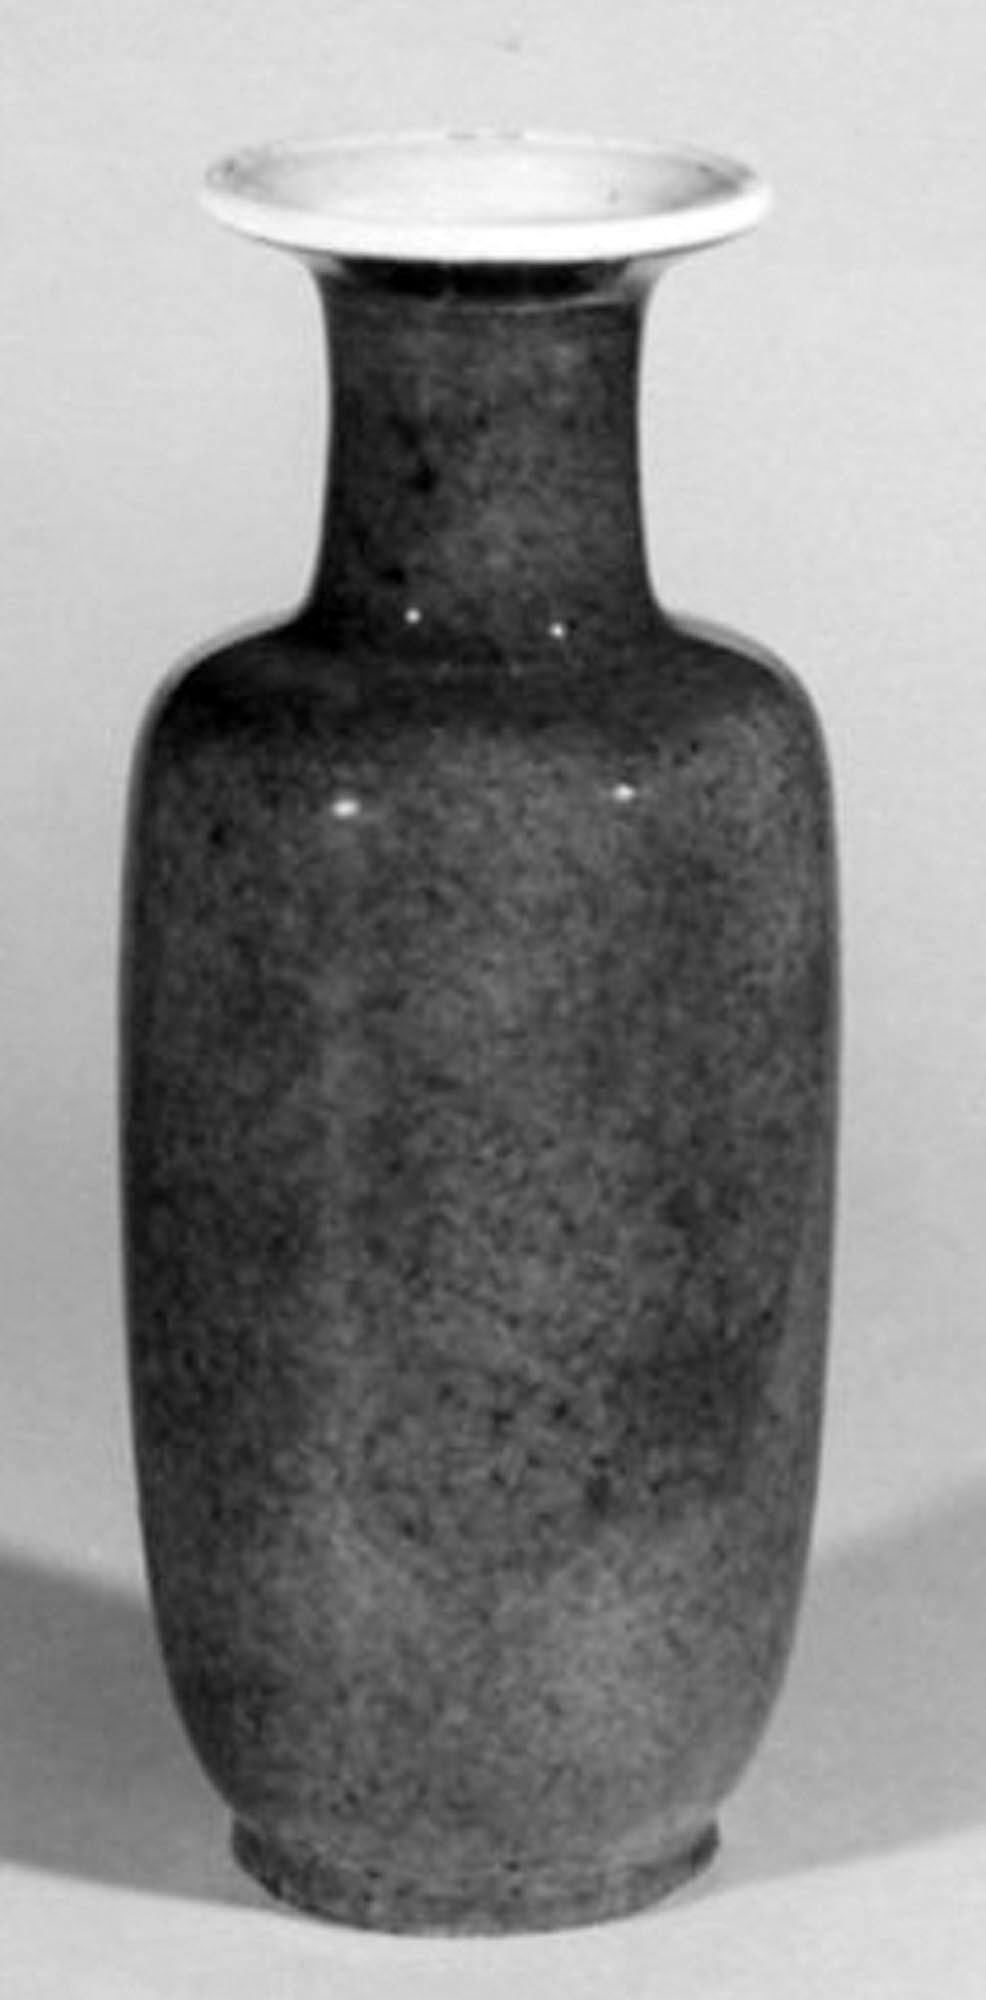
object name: vase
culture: chinese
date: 1662-1722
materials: glaze, porcelain